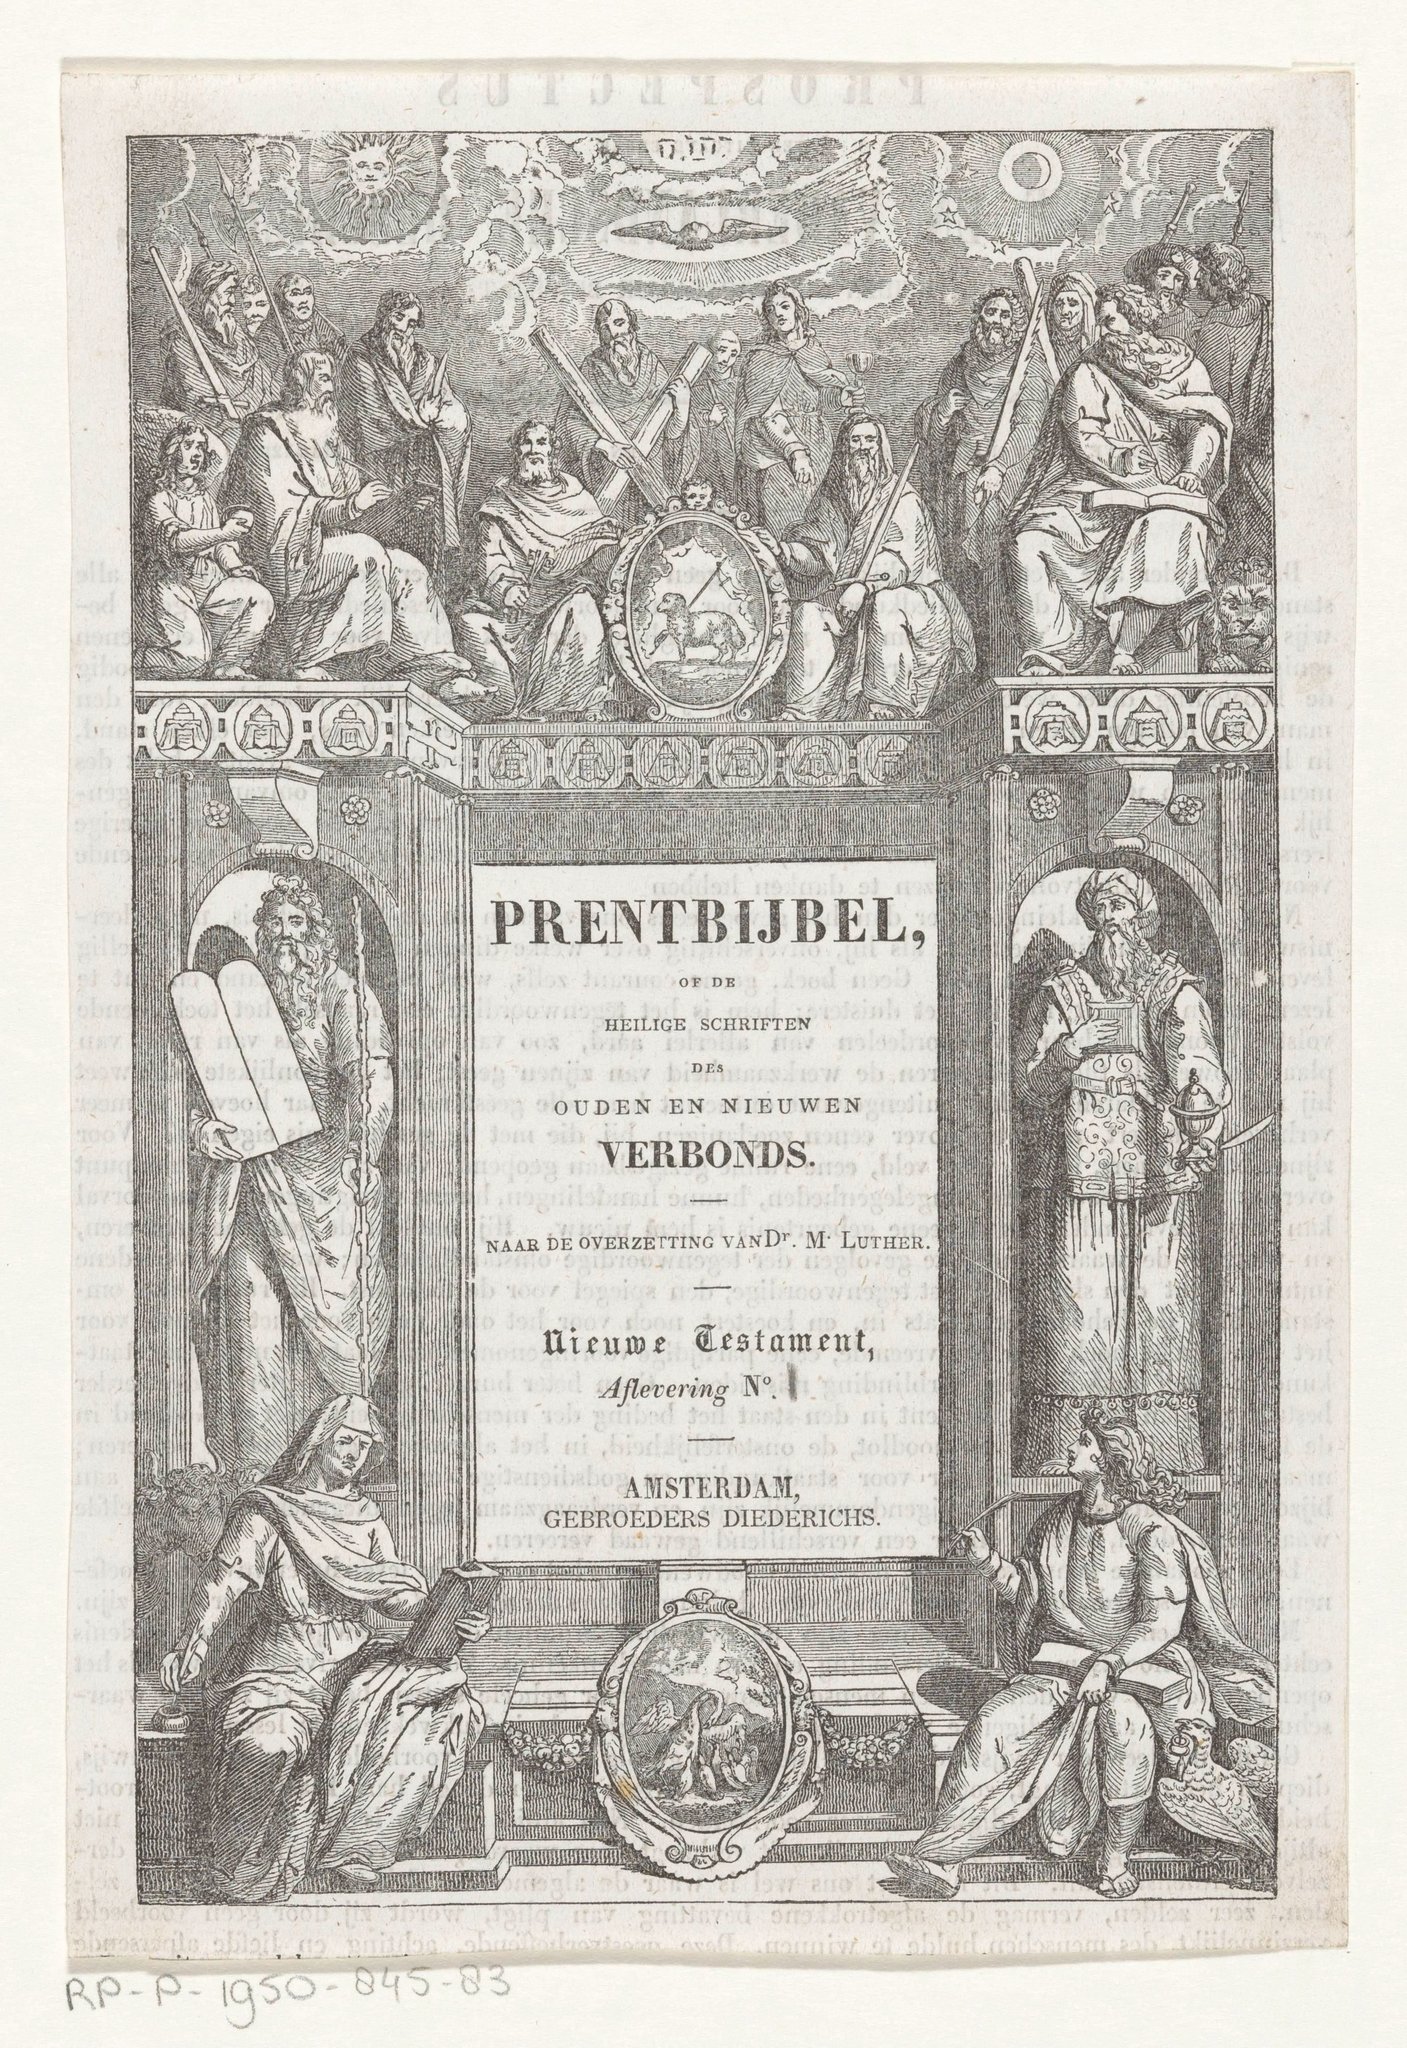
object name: print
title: Evangelisten en apostelen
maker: Anonymous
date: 1840-1860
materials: paper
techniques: letterpress printing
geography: amsterdam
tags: evangelists, usually with books or scrolls (not in biblical context), the twelve apostles (as a group), usually with books or scrolls (not in biblical context)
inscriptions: collector's mark: Lugt 2228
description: Titelpagina voor een bijbel. De titel op een tablet met aan weerszijden Mozes met stenen tafelen (links) en een man met tulband (rechts), staand in nissen. Voor en boven de nissen zitten de vier evangelisten met bijbehorende wezens. Tussen Lukas en Johannes (onder) een medaillon met een pelikaan die zijn jongen voedt. Tussen Matteüs en Markus (boven) een medaillon met het Lam Gods. Daarachter staan de twaalf apostelen.